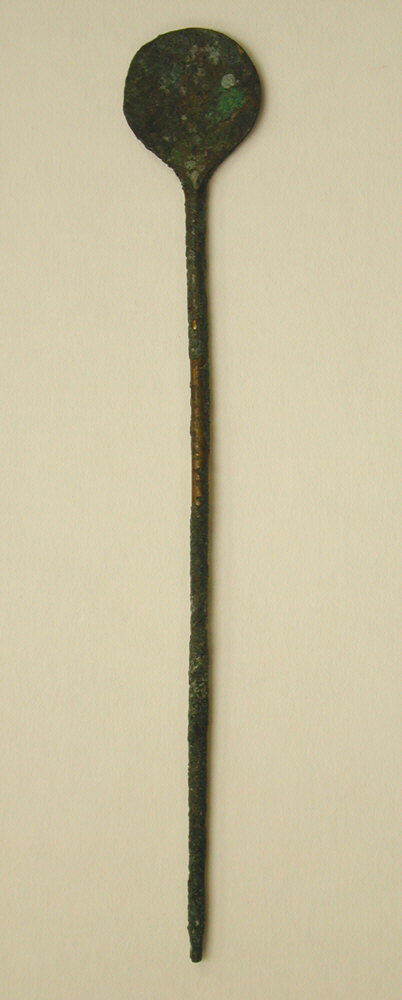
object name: pin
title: Tupu (pin)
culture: tiwanaku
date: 1601-1700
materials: copper, gold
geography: peru